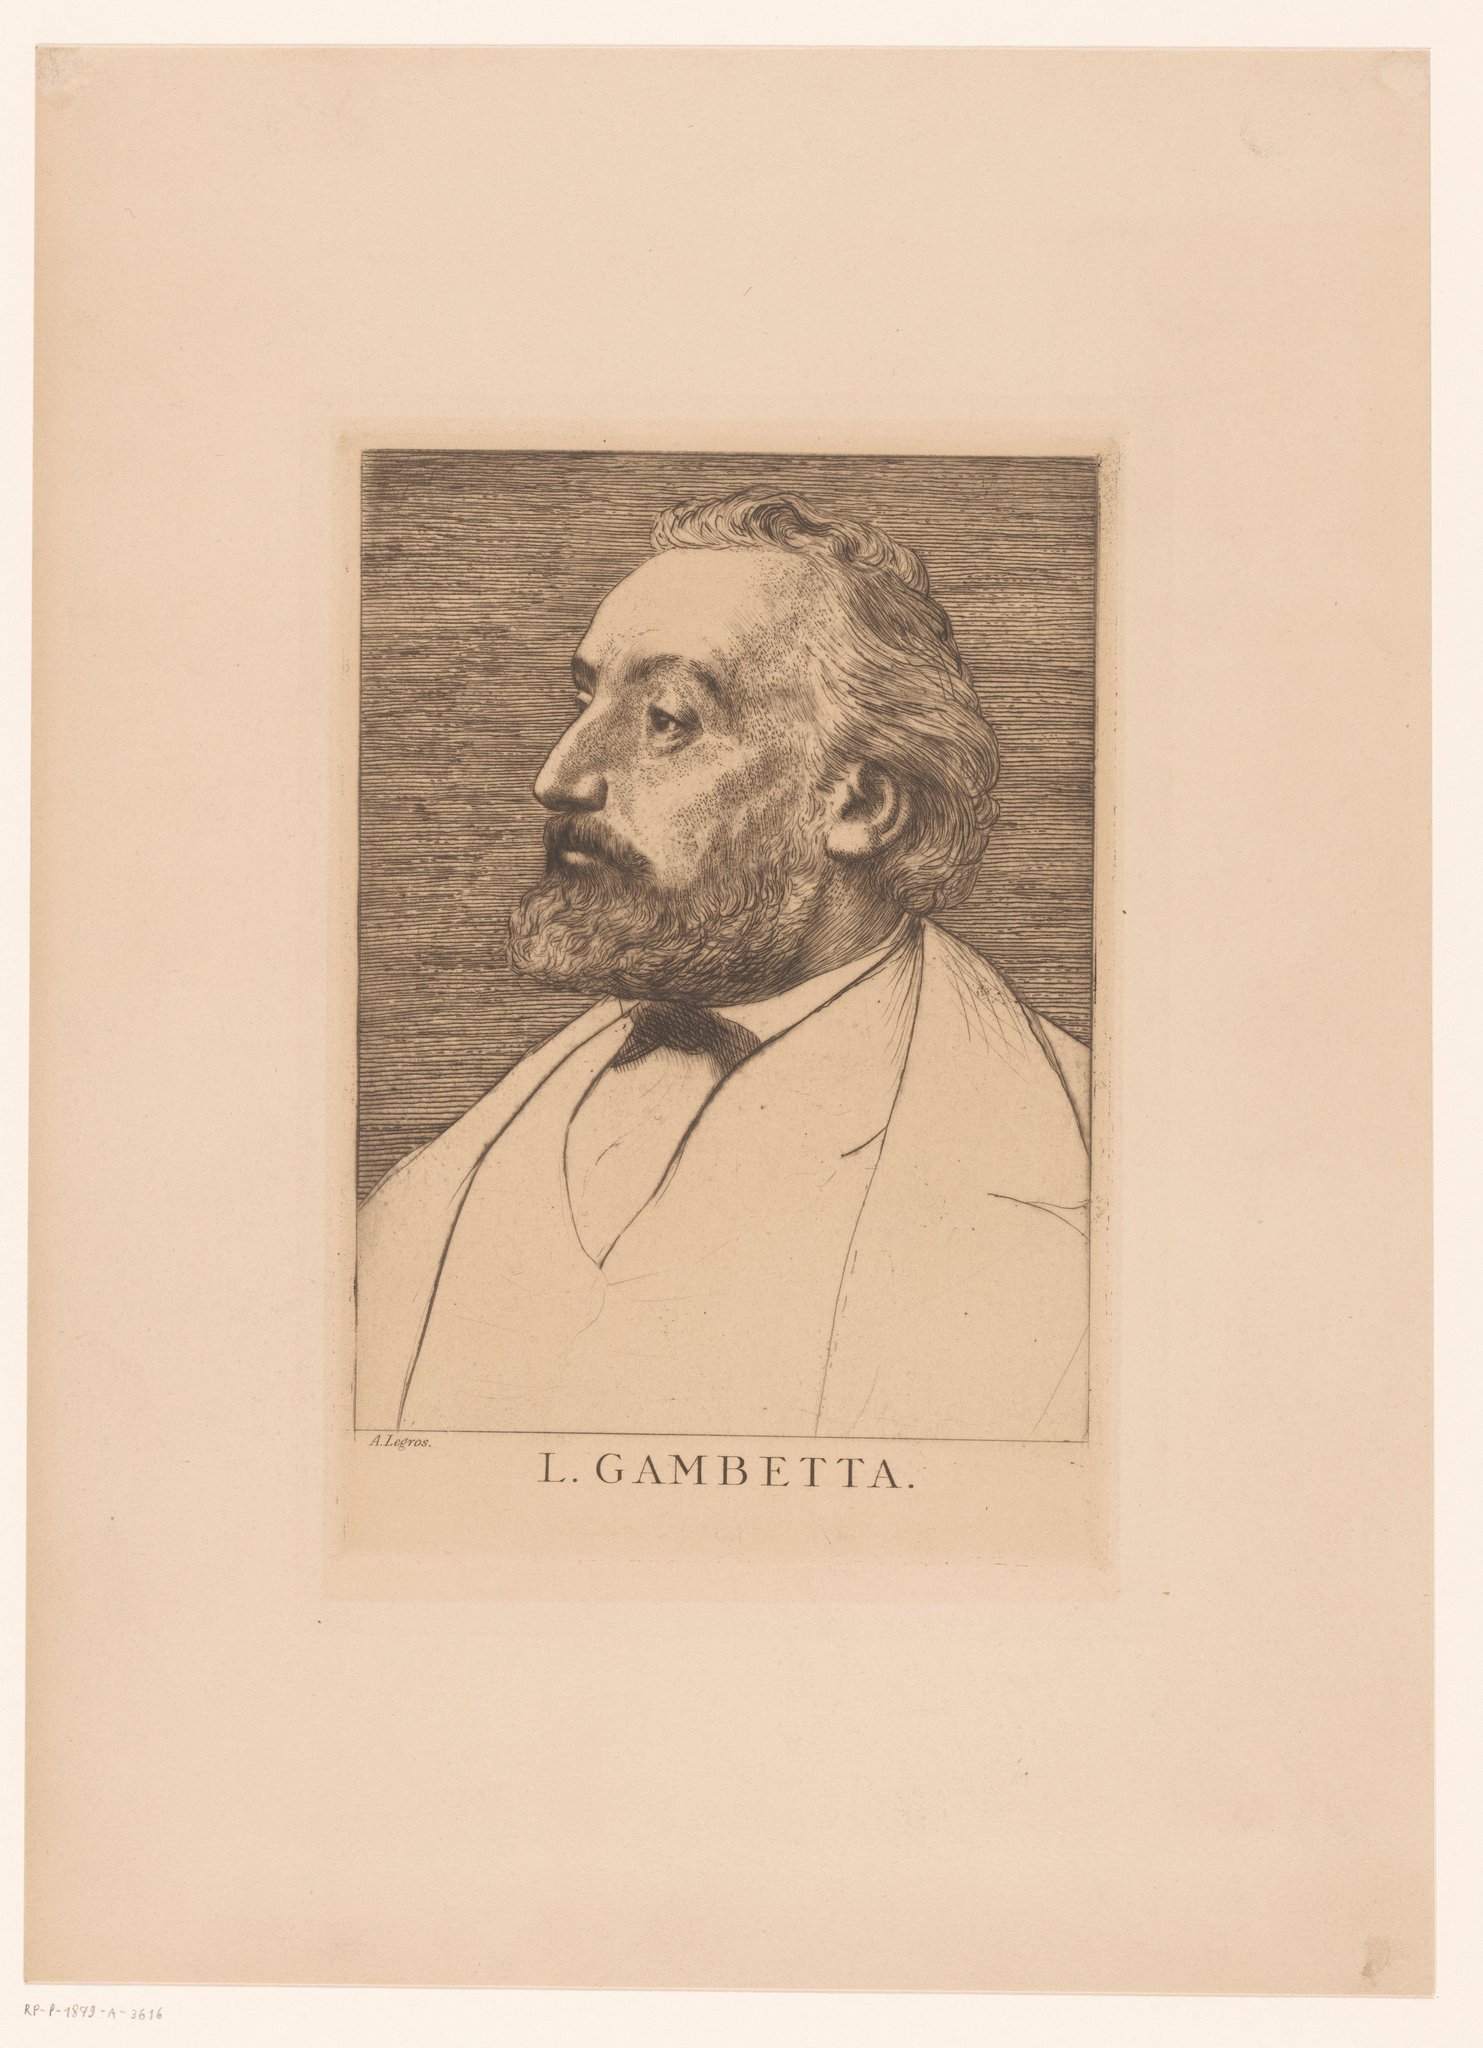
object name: print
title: L. Gambetta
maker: alphonse legros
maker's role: print maker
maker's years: 1837-1911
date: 1877-1879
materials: paper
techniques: drypoint, engraving, etching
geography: france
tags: historical persons, politician, e.g. party leader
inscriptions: collector's mark: Lugt 2228